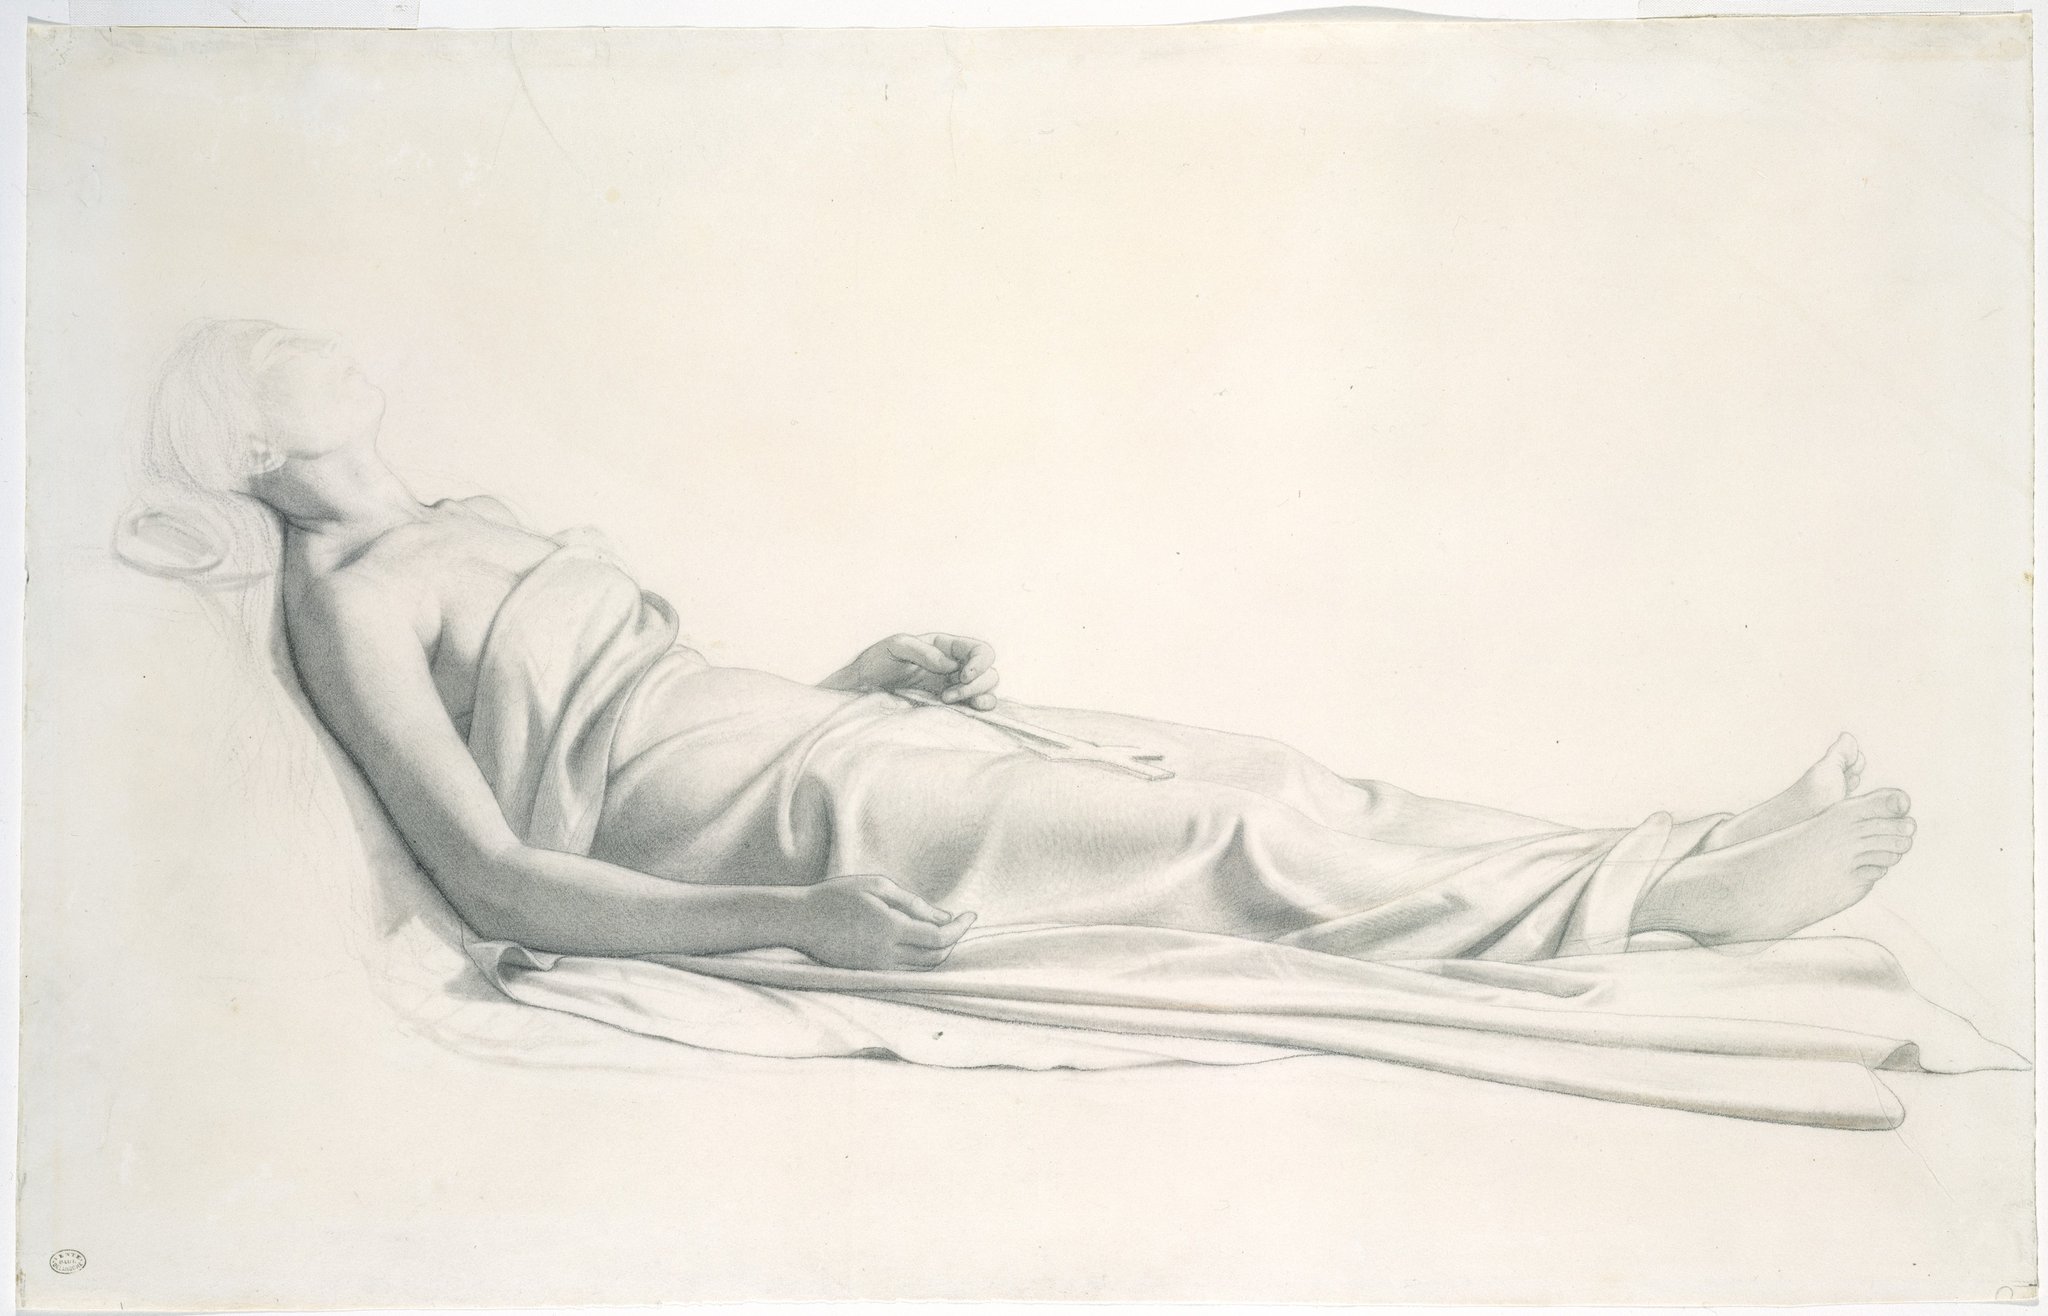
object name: drawing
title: Drapery Study for the Figure of the Dying Mary Magdalen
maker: paul (hippolyte) delaroche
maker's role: draftsman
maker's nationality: french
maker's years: 1797-1856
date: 1815-1856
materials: chalk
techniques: stumping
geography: france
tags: suffering,mary magdalene